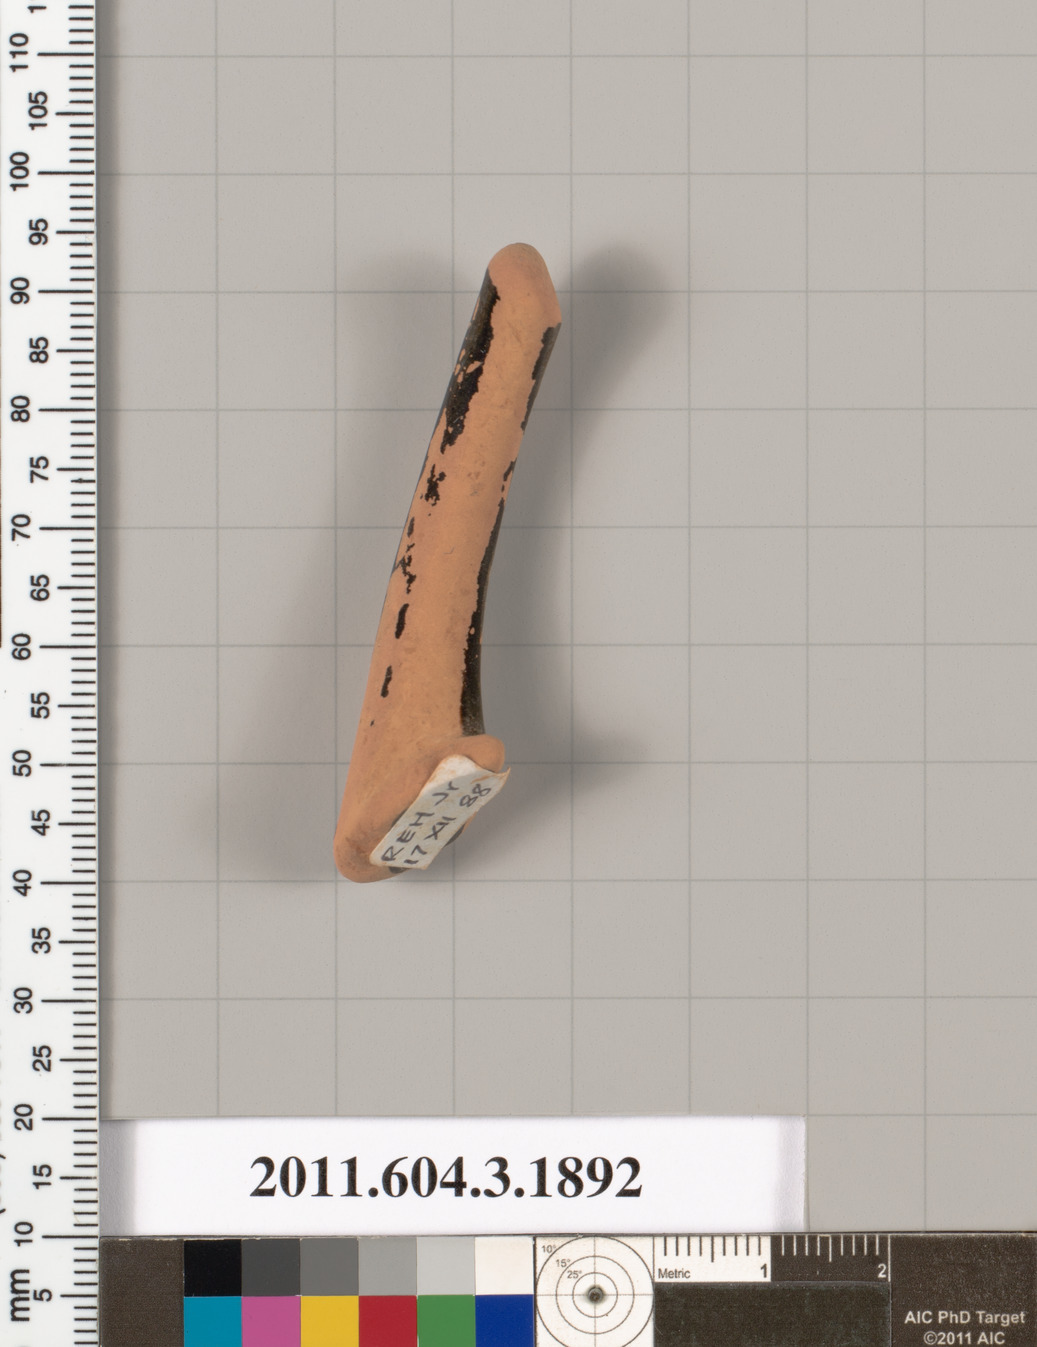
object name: kylix or skyphos fragment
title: Terracotta fragment of a kylix (drinking cup) or a skyphos (deep drinking cup)?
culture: greek, attic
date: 600-401 BCE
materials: terracotta